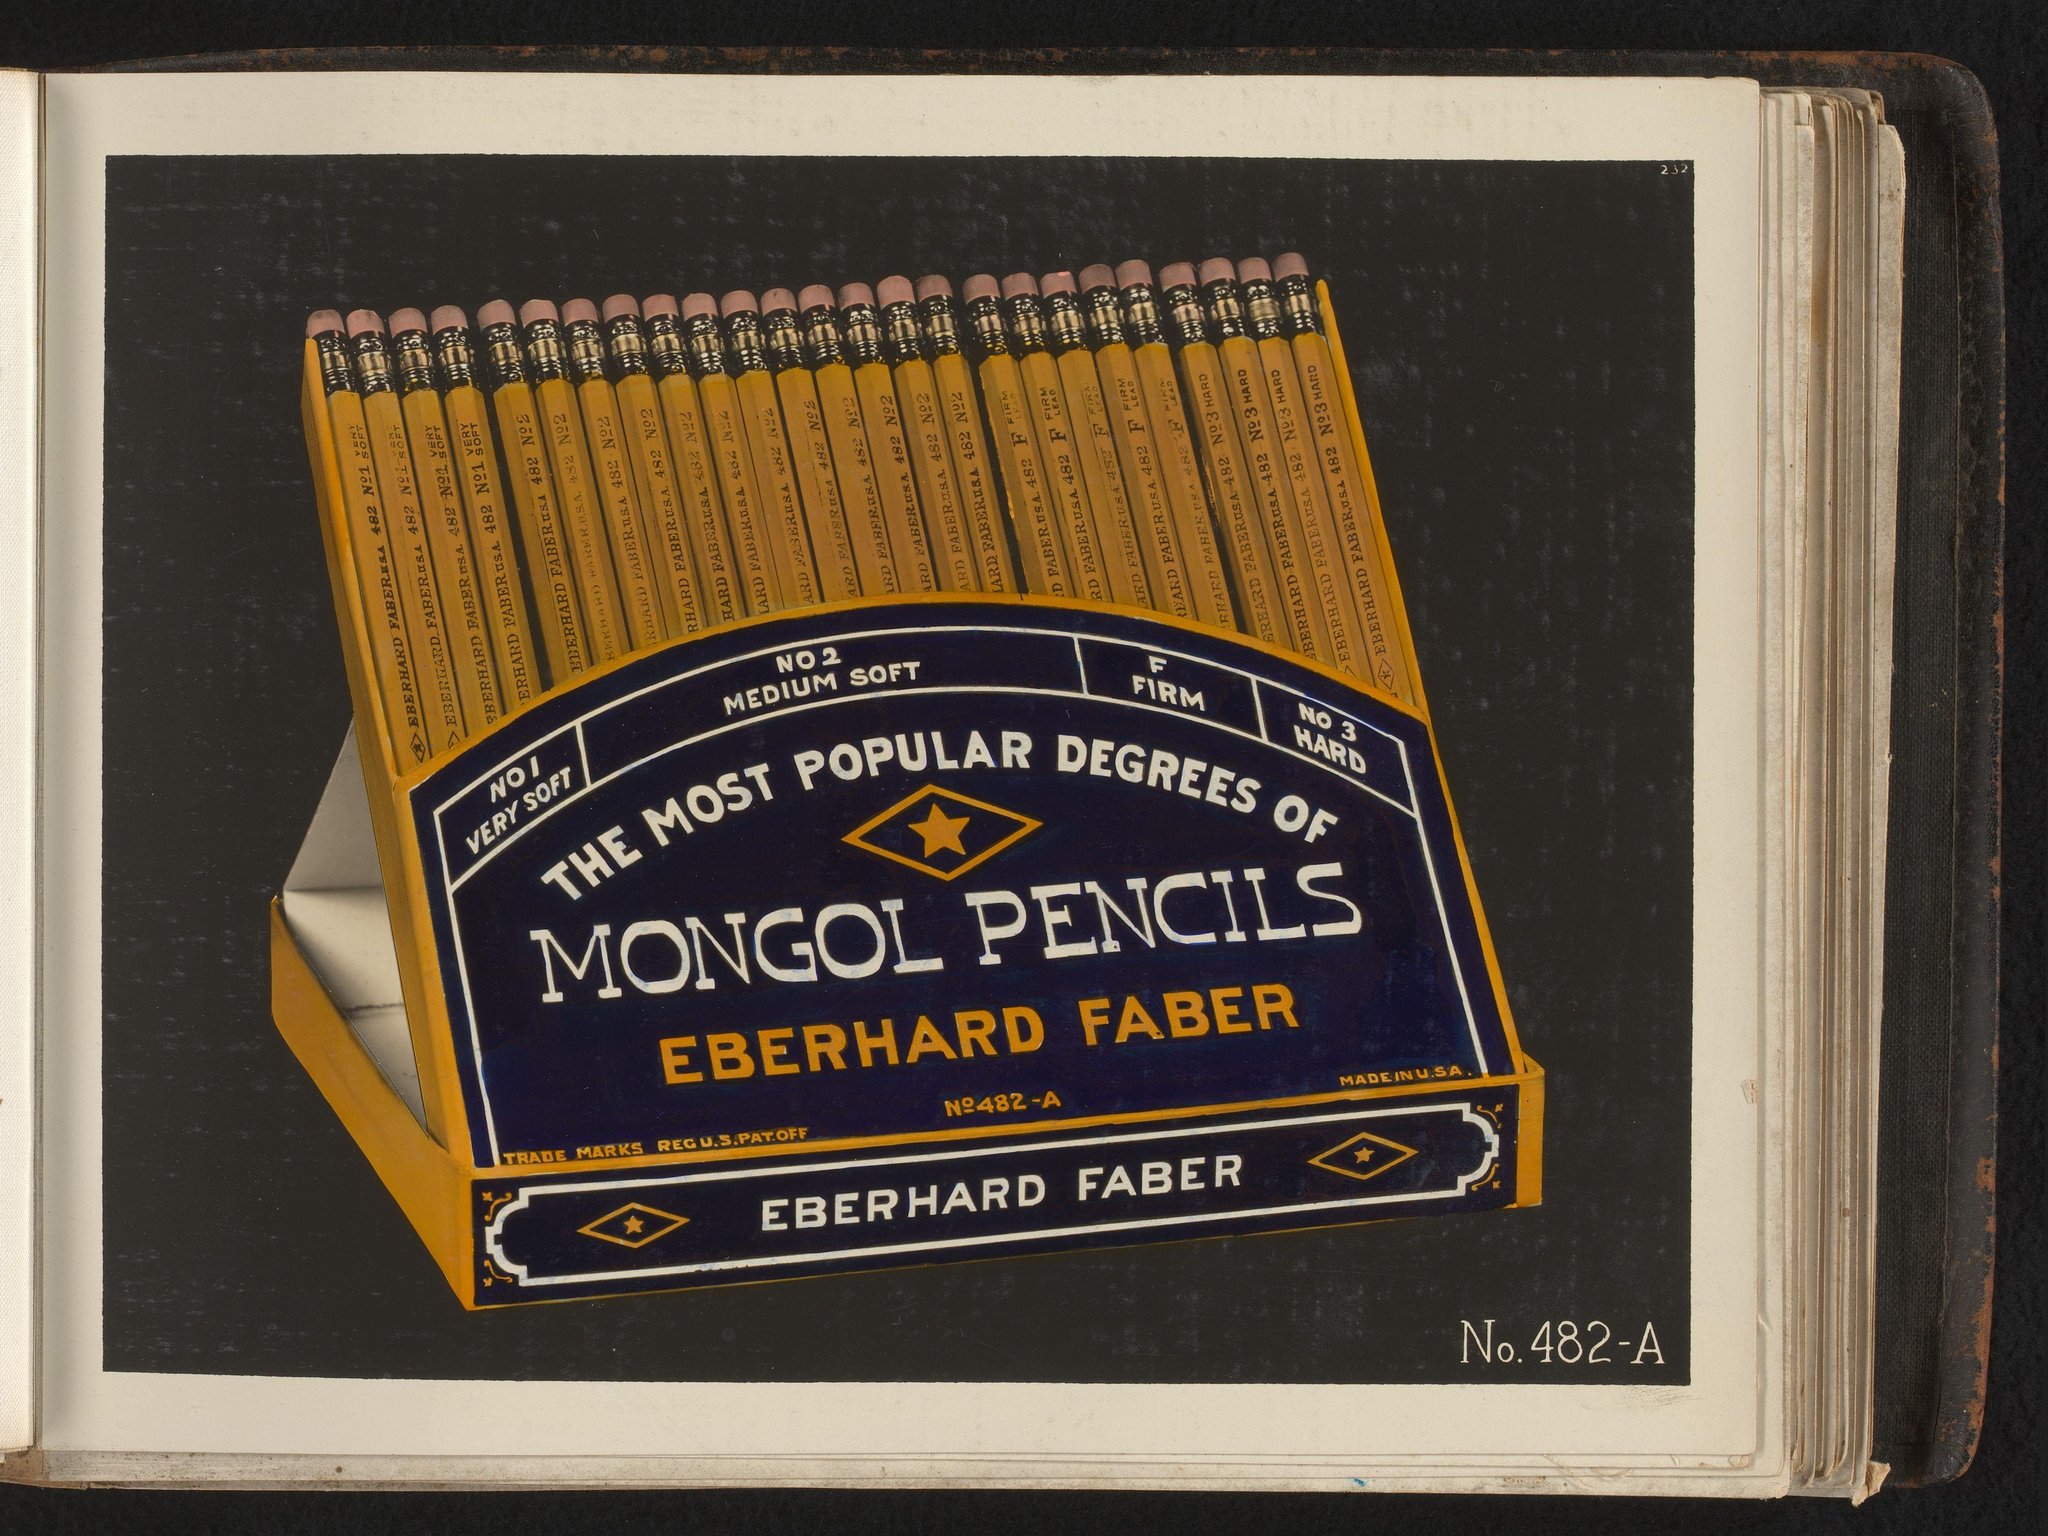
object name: photograph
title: Standaard met potloden van Eberhard Faber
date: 1915-1935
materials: paper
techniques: gelatin silver print, hand coloring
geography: springfield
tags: pencil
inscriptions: number: ‘232’, stamp: ‘Paramount/ Commercial Studios/ 145 Chestnut St./ Springfield - Mass.’